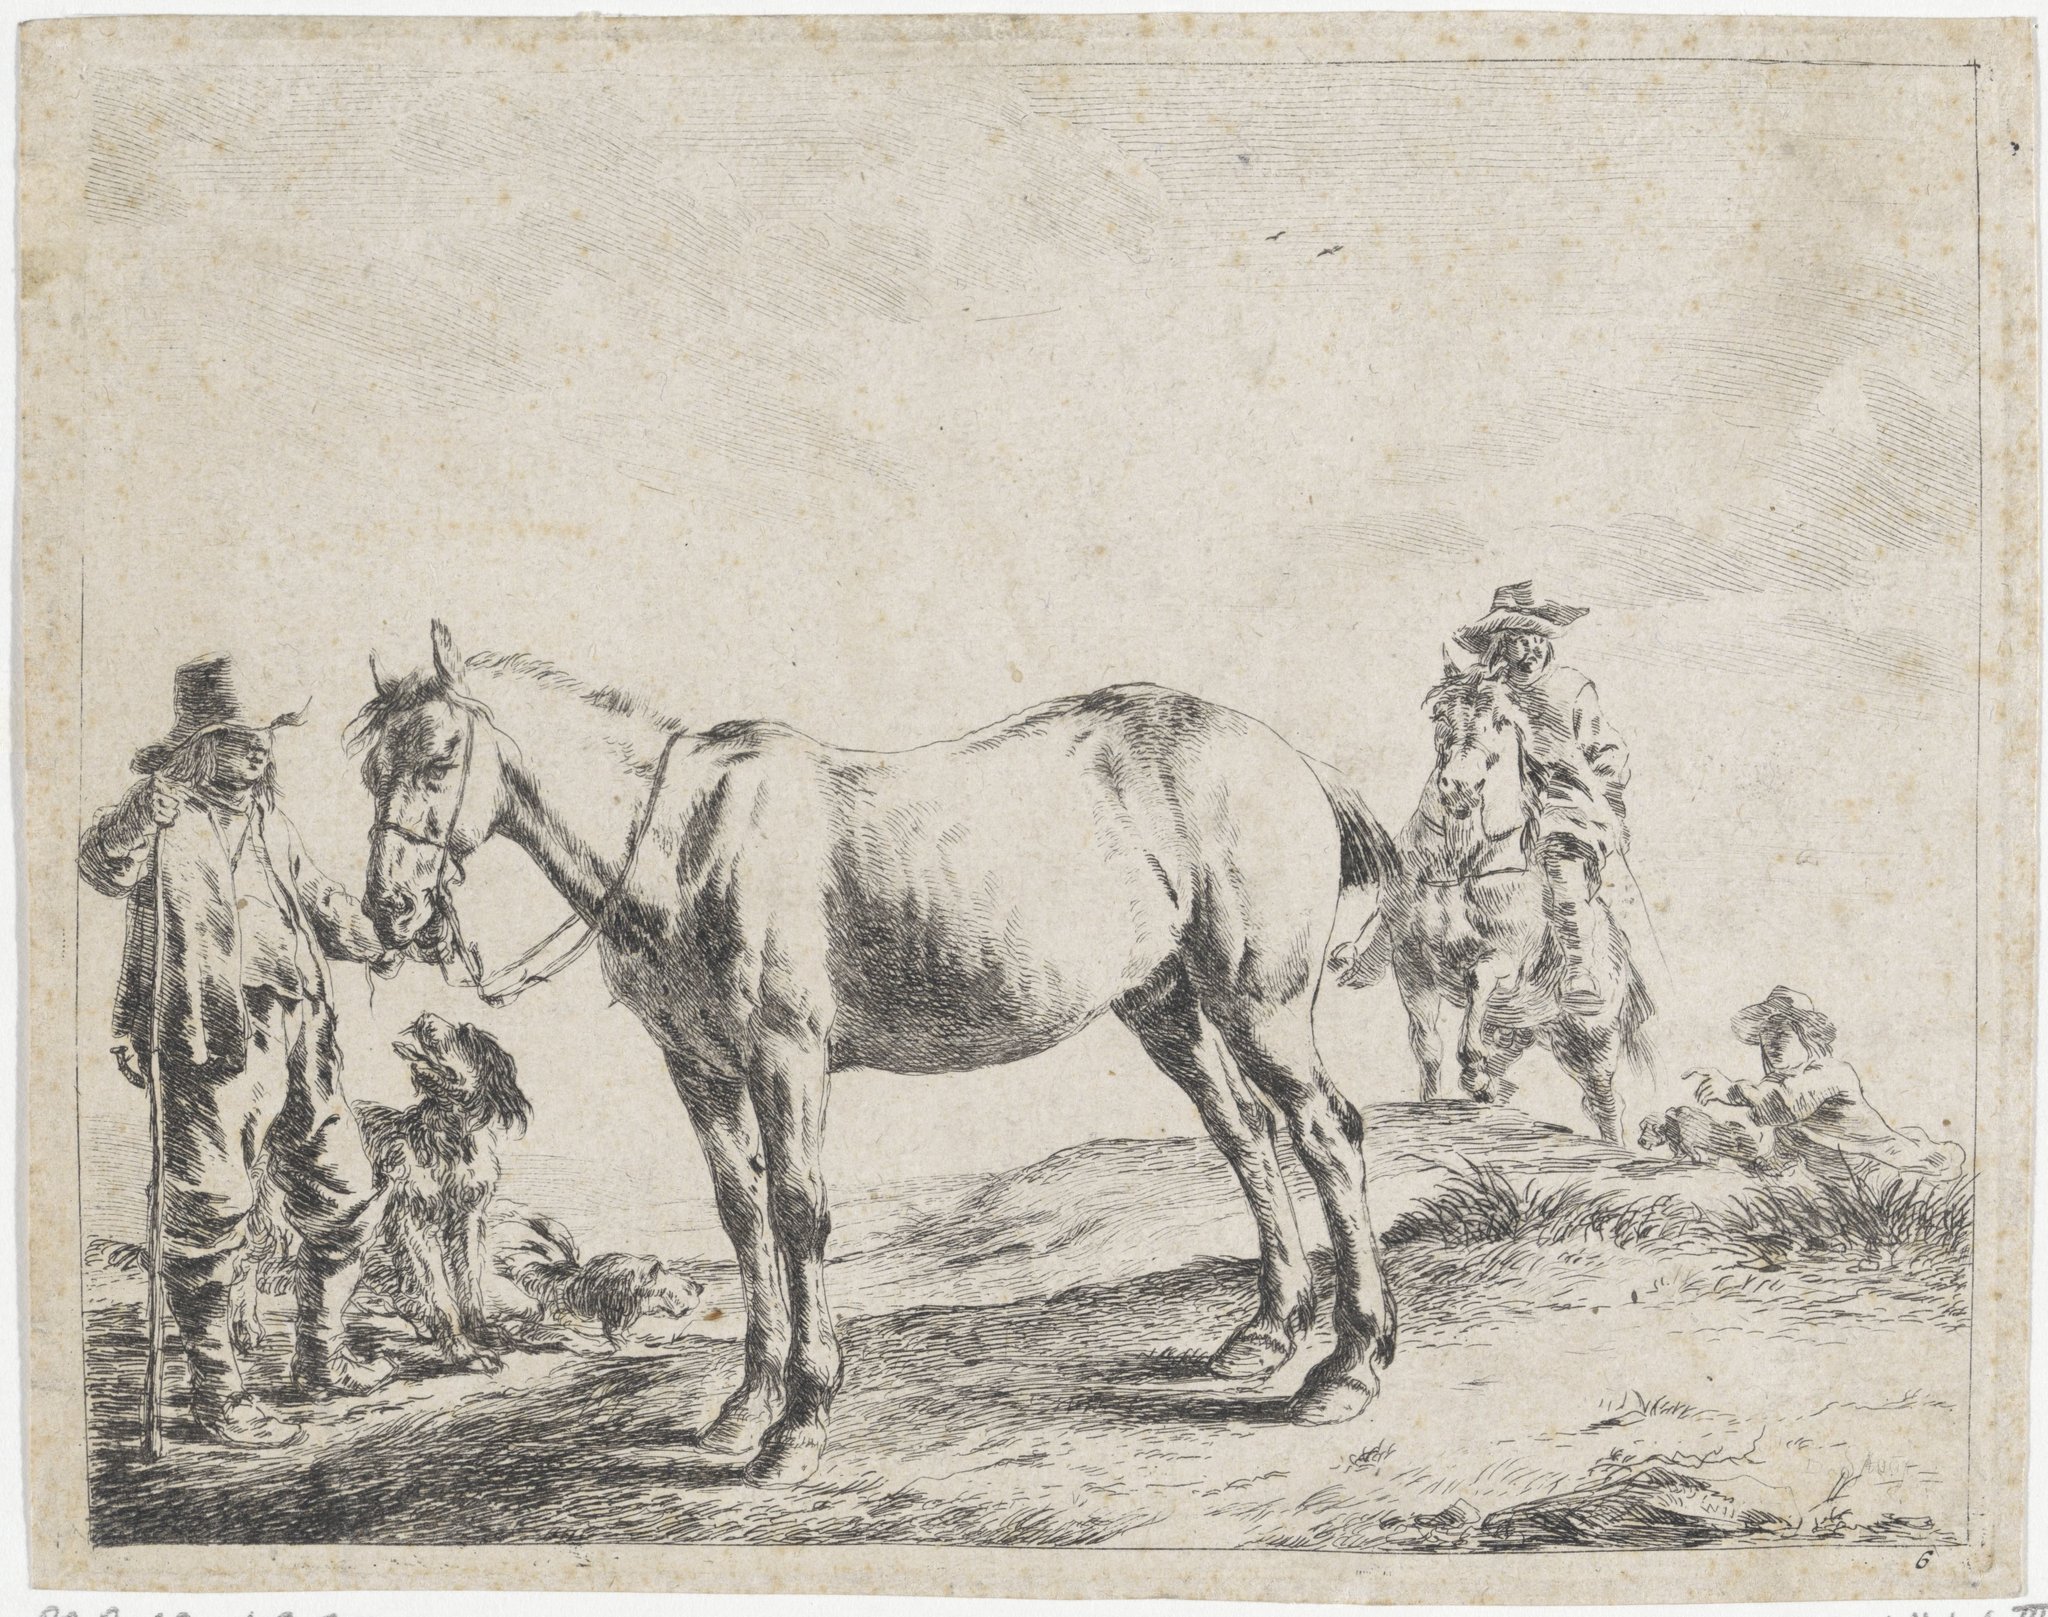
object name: print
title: Paarden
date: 1651-1706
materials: paper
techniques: etching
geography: utrecht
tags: horse, dog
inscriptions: collector's mark: Lugt 2228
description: Een man houdt een paard bij de teugels. Naast hem twee honden. Rechts een ruiter en een wijzende man.